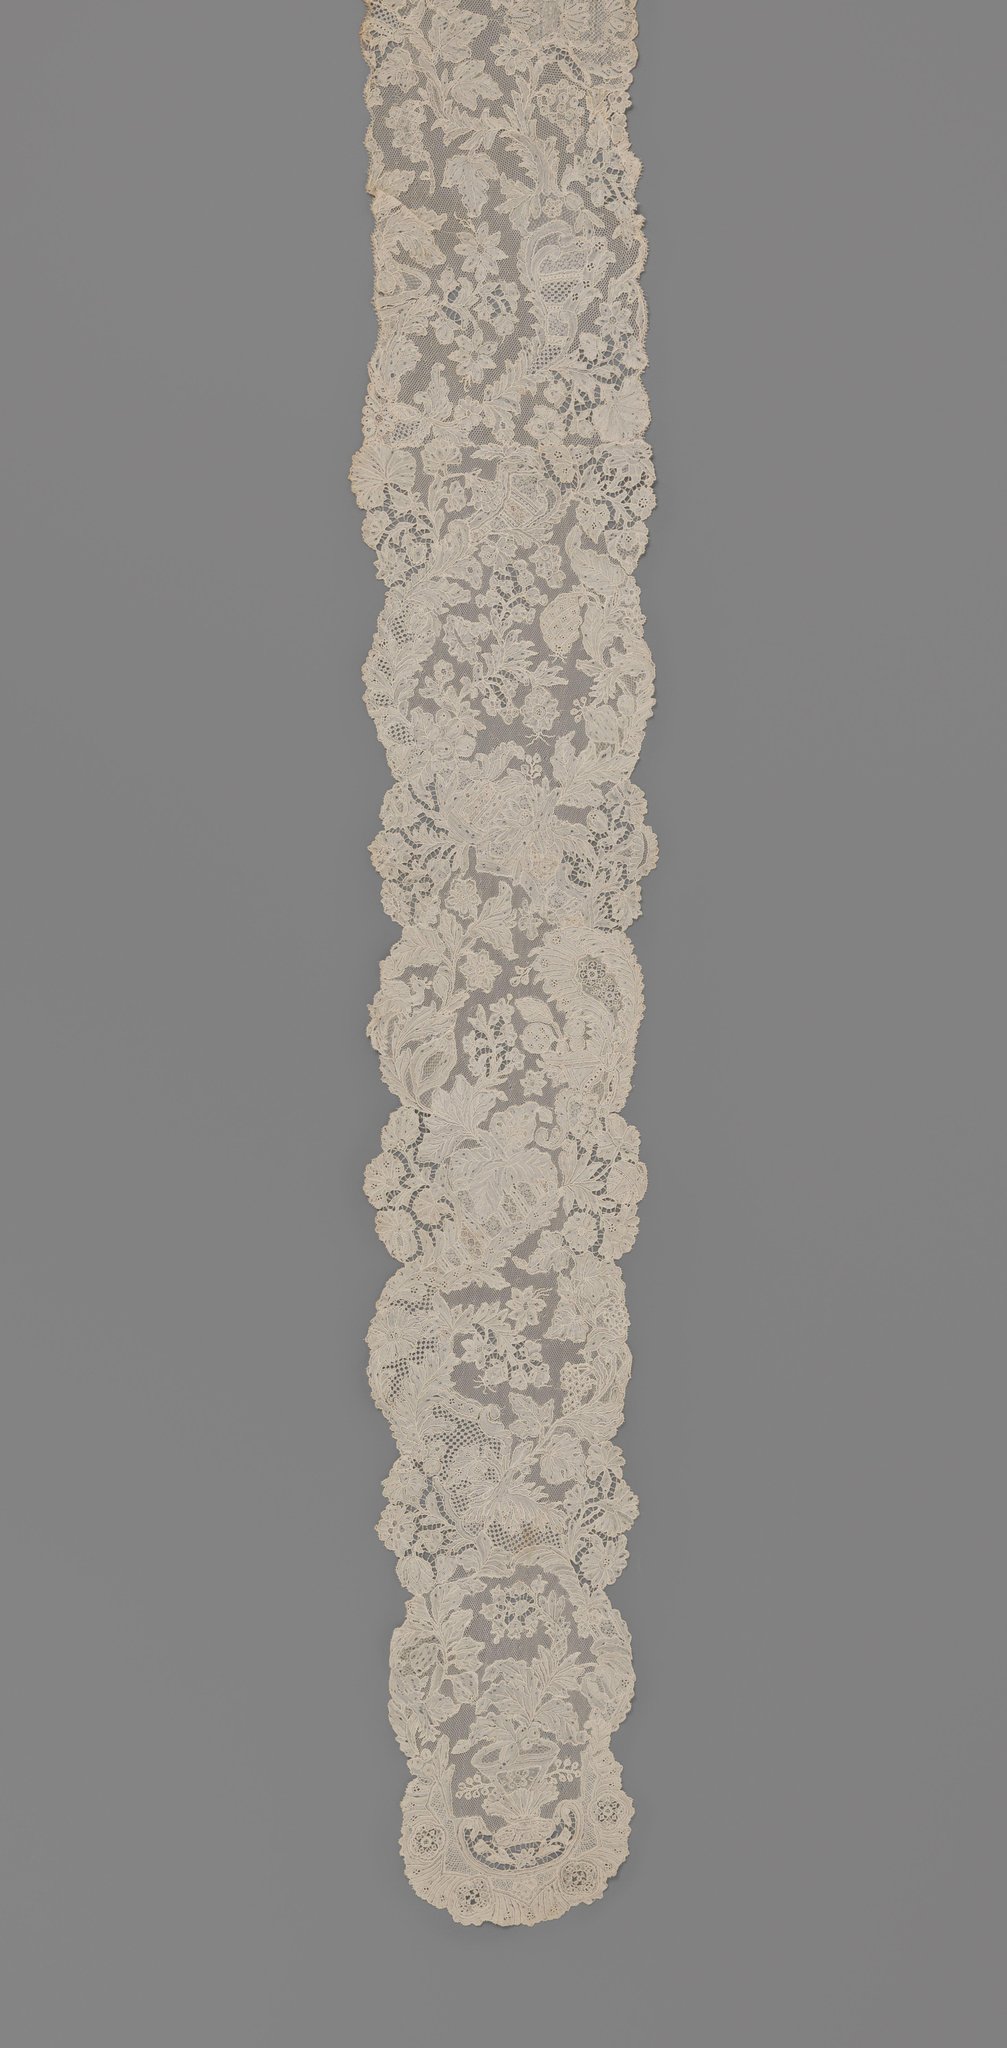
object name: womenswear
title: Fontange van Vieux Bruxelles kant; de achtergrond is van kloskant, het ornament is van naaldkant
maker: Anonymous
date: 1740-1750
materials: lace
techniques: lace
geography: brussels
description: Fontange van naald- en kloskant, bestaande uit twee slippen, waartussen een verlengstuk is genaaid. In het midden heeft het patroon een palmetmotief en aan weerszijden hoornen, veermotieven, schuine ranken en diverse siersteken gehecht in de grond of drochel. Aan de beide uiteinden is een vaas met een boeket gewerkt, terwijl bloemen en bladeren de geschulpte omtrek vormen.